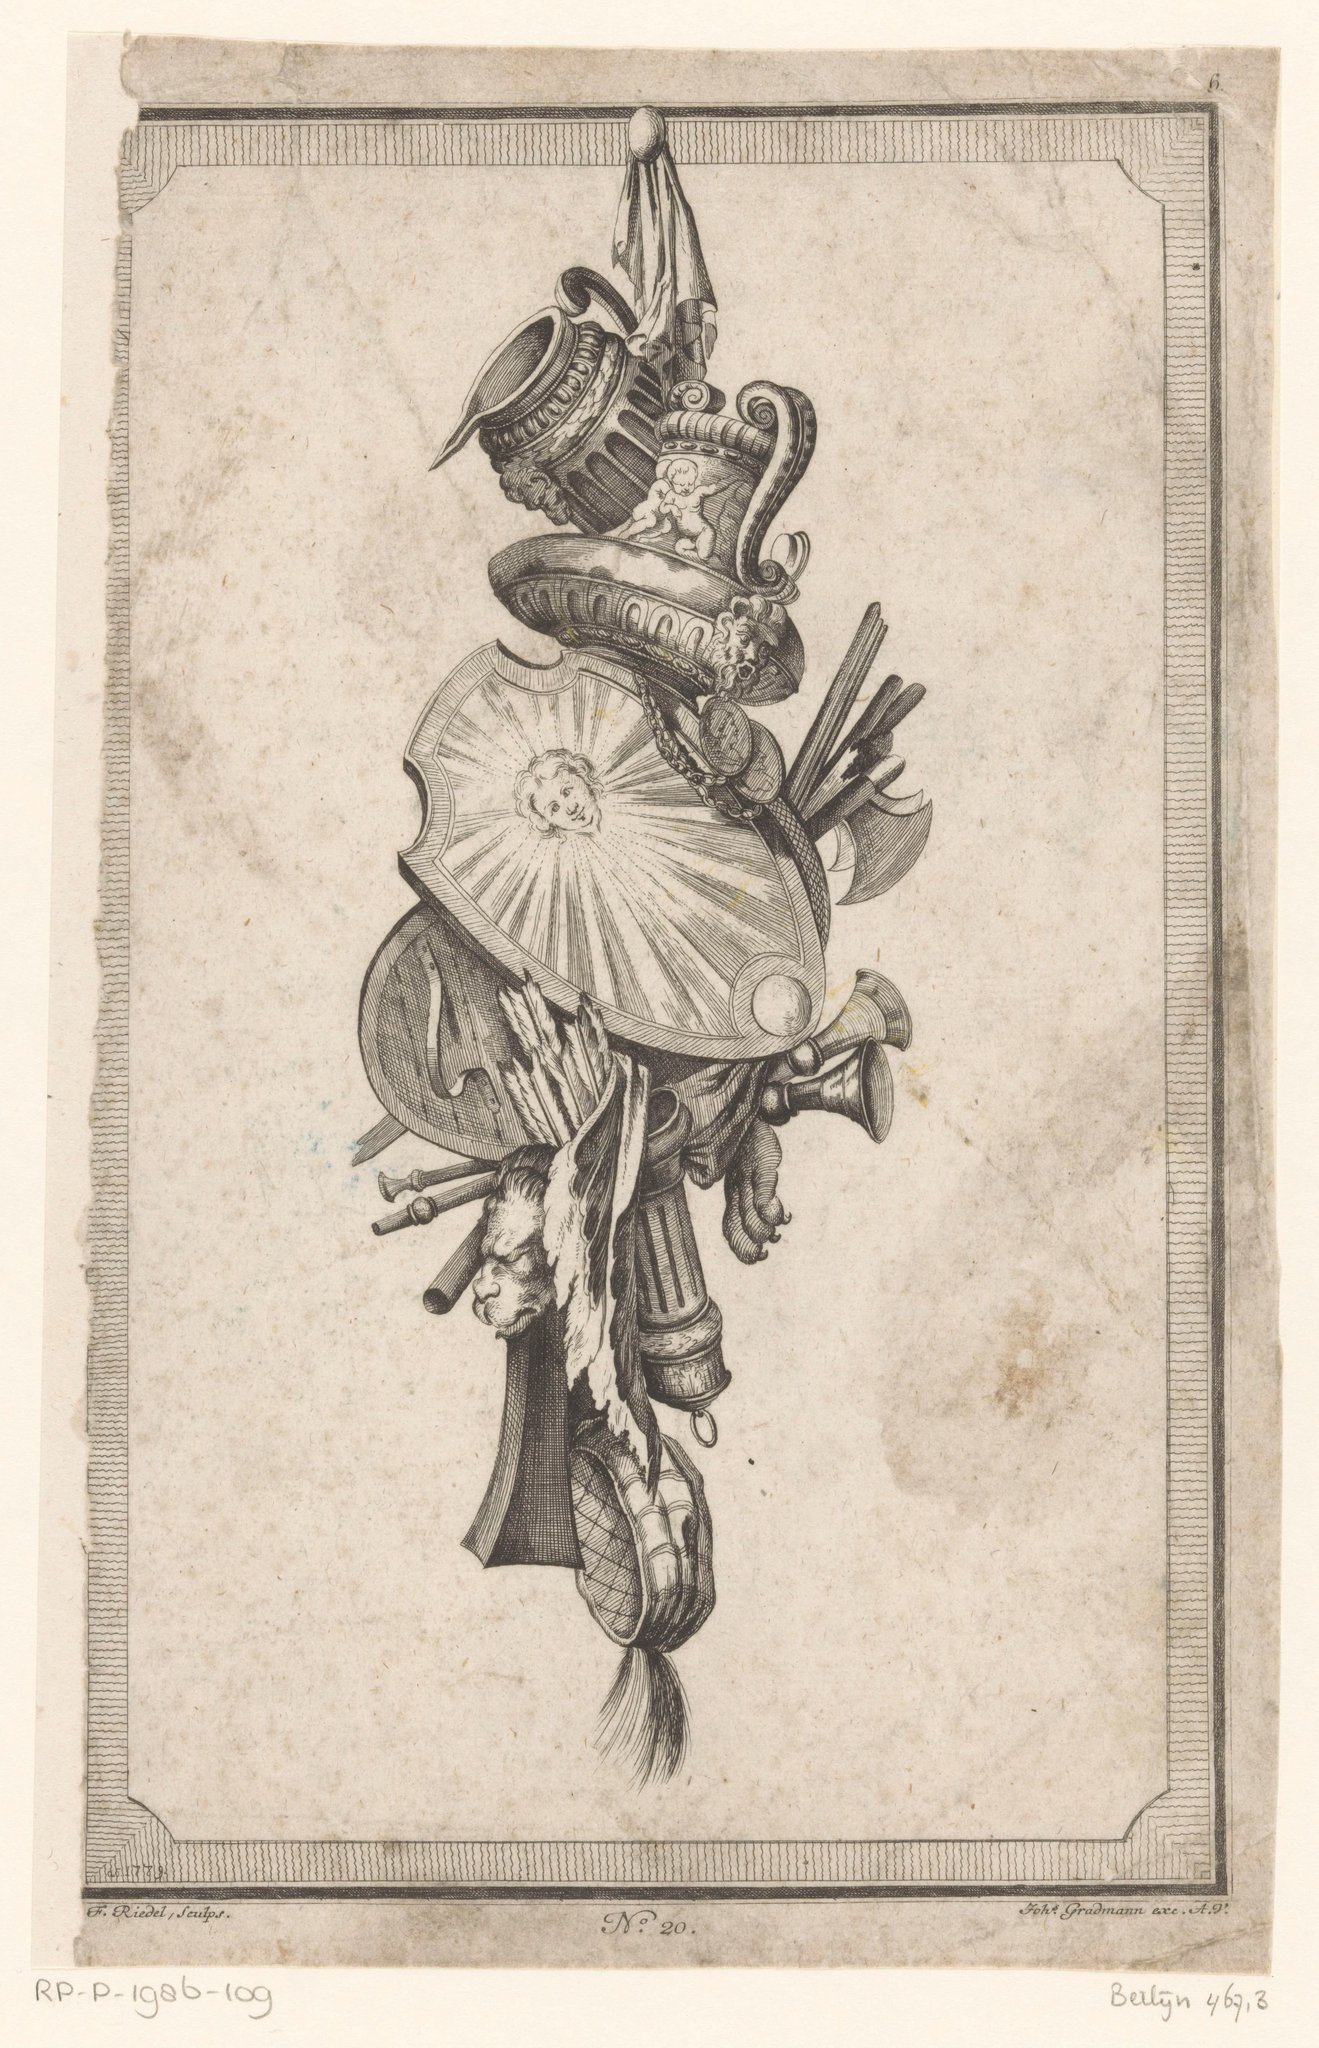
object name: ornament print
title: Trofee met vazen en schild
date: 1779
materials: paper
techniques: engraving, etching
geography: augsburg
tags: protective weapons: shield, trophy, i.e.: decorative arrangement of symbolic or typical objects ~ ornament, vase ~ ornament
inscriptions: collector's mark: Lugt 2228, collector's mark: Lugt 2760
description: Een trofee met vazen, wapens, een schild met de zon en dierenvellen. Uitgeversnummer 20.